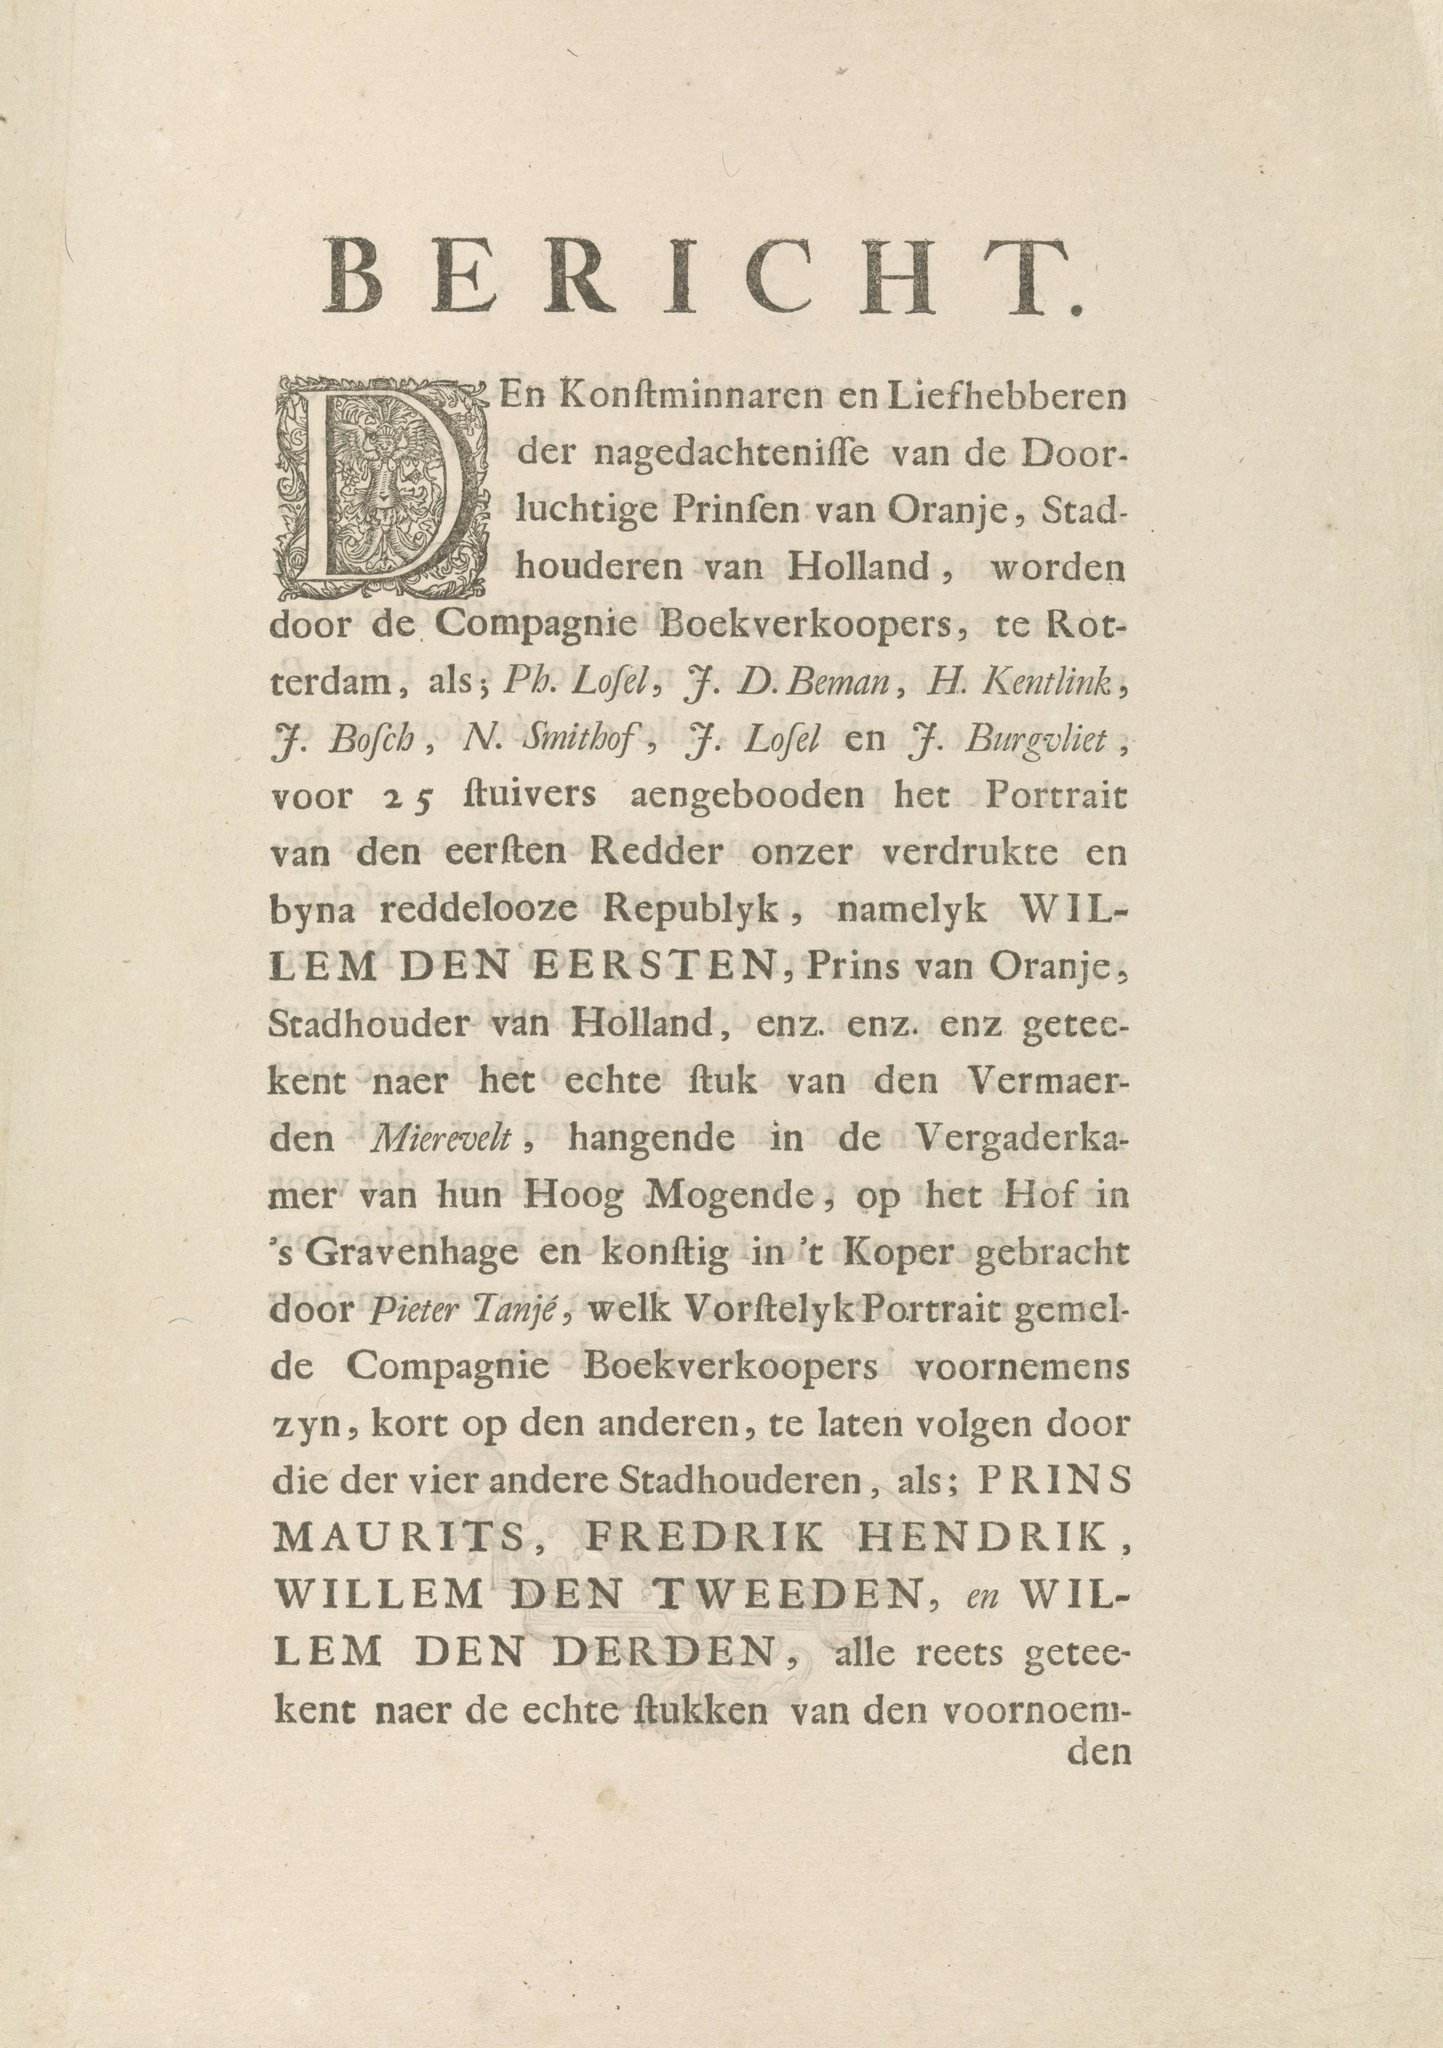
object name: uitgeversprospectus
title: Bericht bij de uitgave van zes portretten van stadhouders en vorsten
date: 1748-1751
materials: paper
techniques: letterpress printing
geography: rotterdam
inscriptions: collector's mark: Lugt 2228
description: Bericht bij de uitgave van zes portretten van stadhouders en vorsten door Pieter Tanjé gegraveerd.